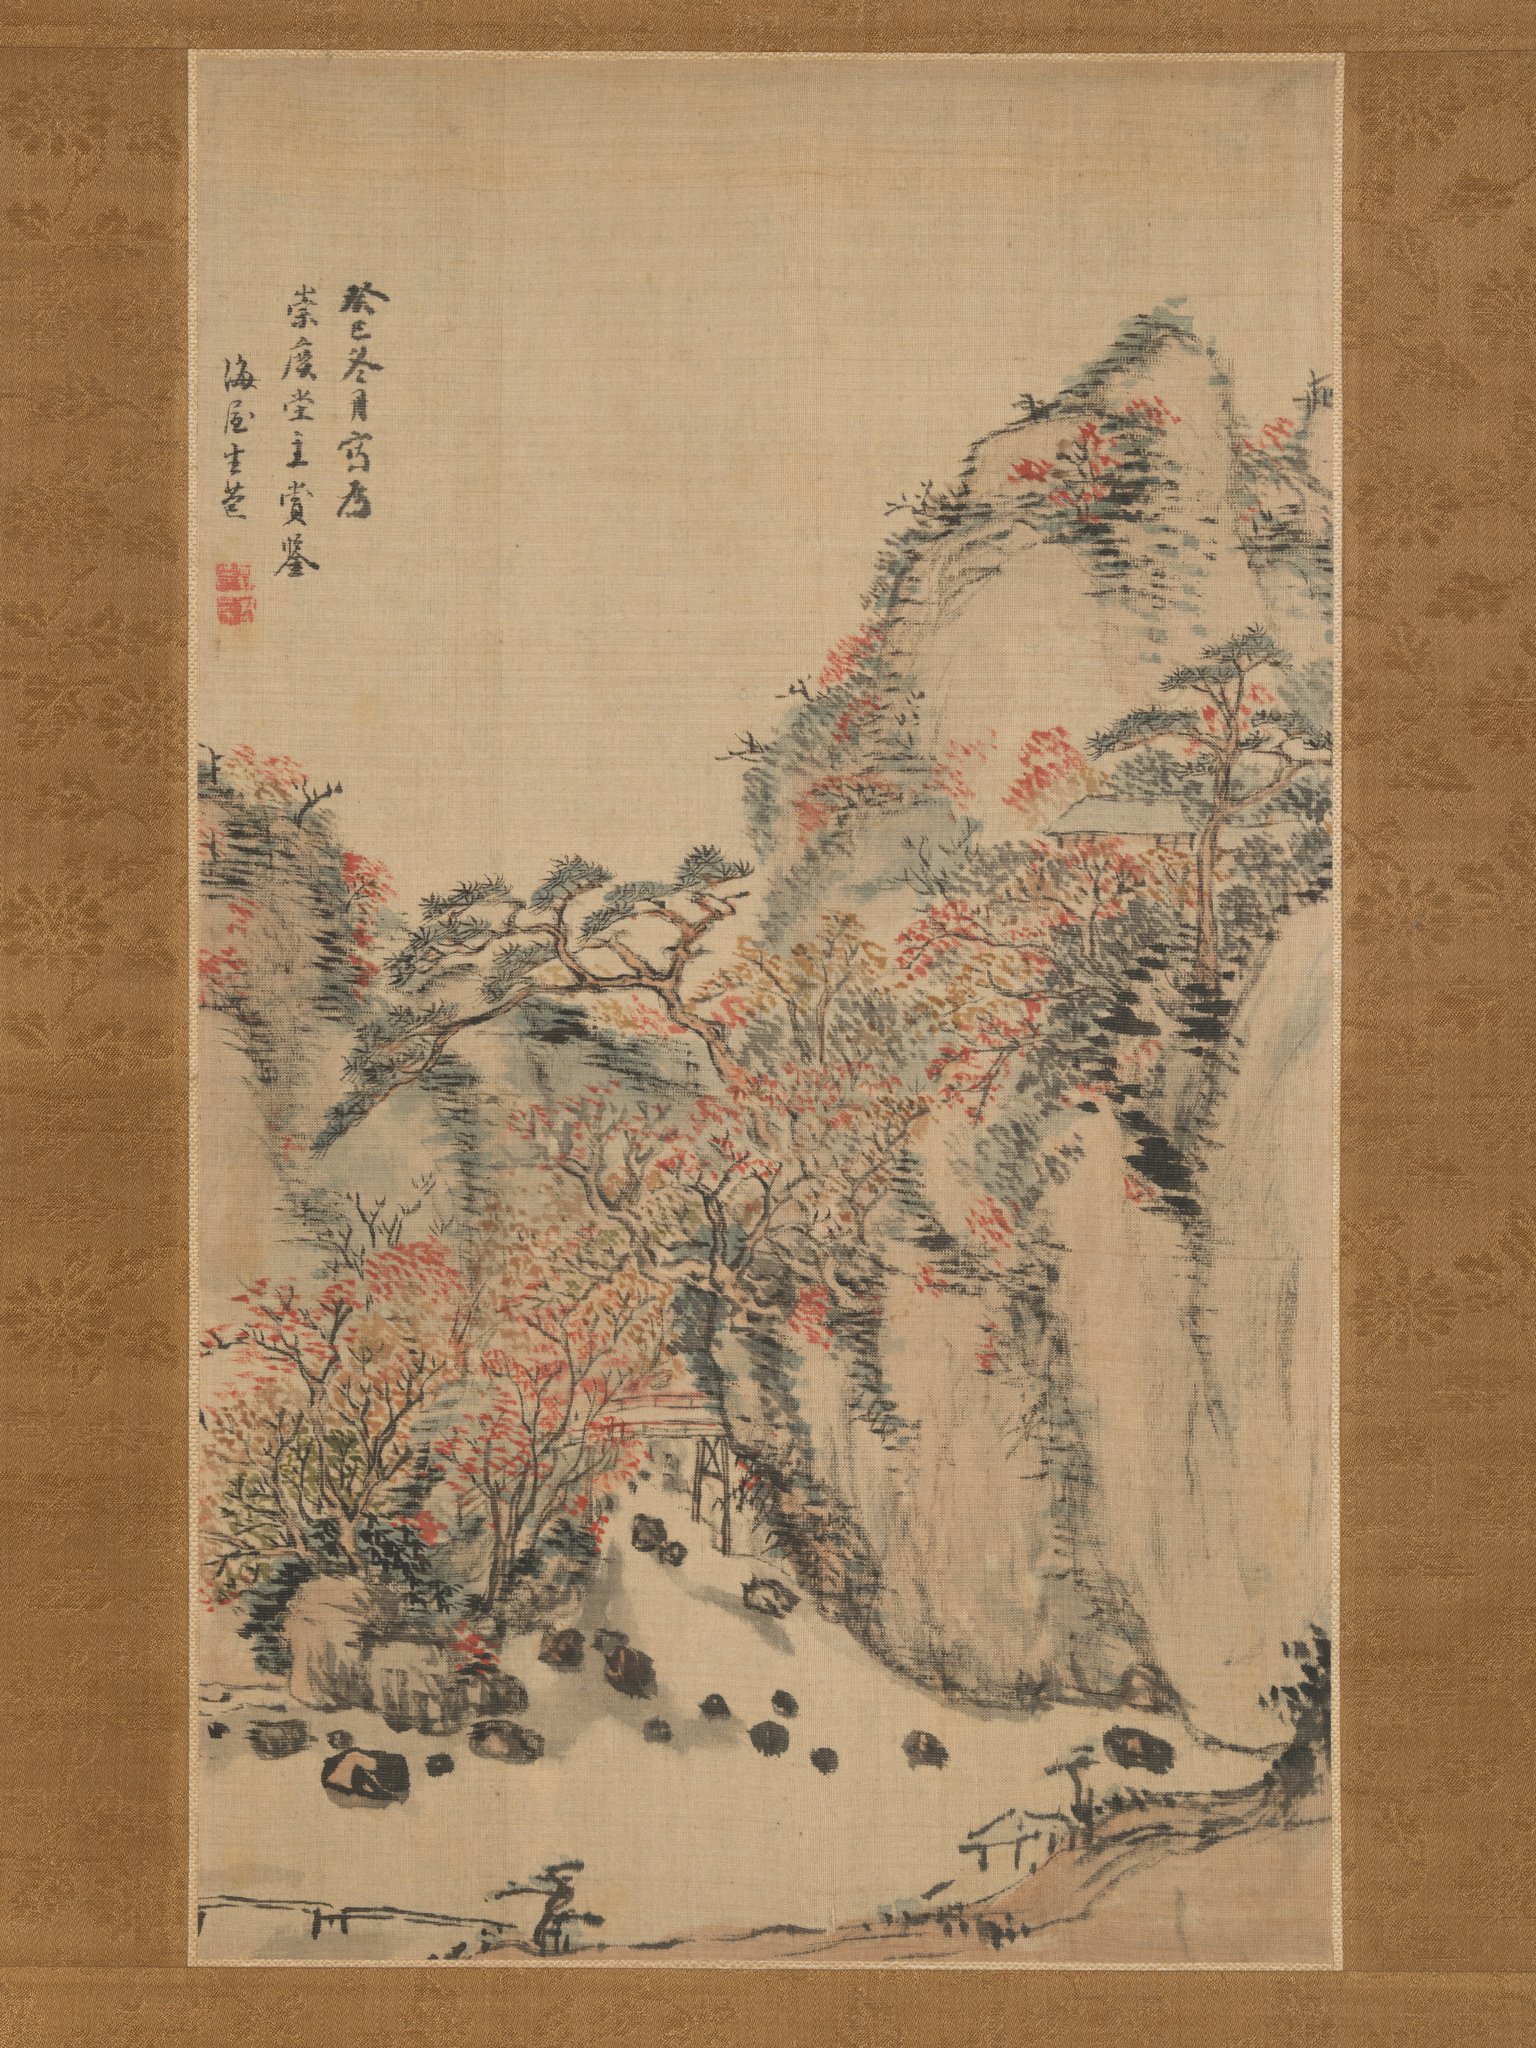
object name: hanging scroll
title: Autumn Landscape at Eigenji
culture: japanese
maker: nukina kaioku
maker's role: artist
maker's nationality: japanese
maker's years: 1778-1863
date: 1833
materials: ink, silk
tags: landscapes